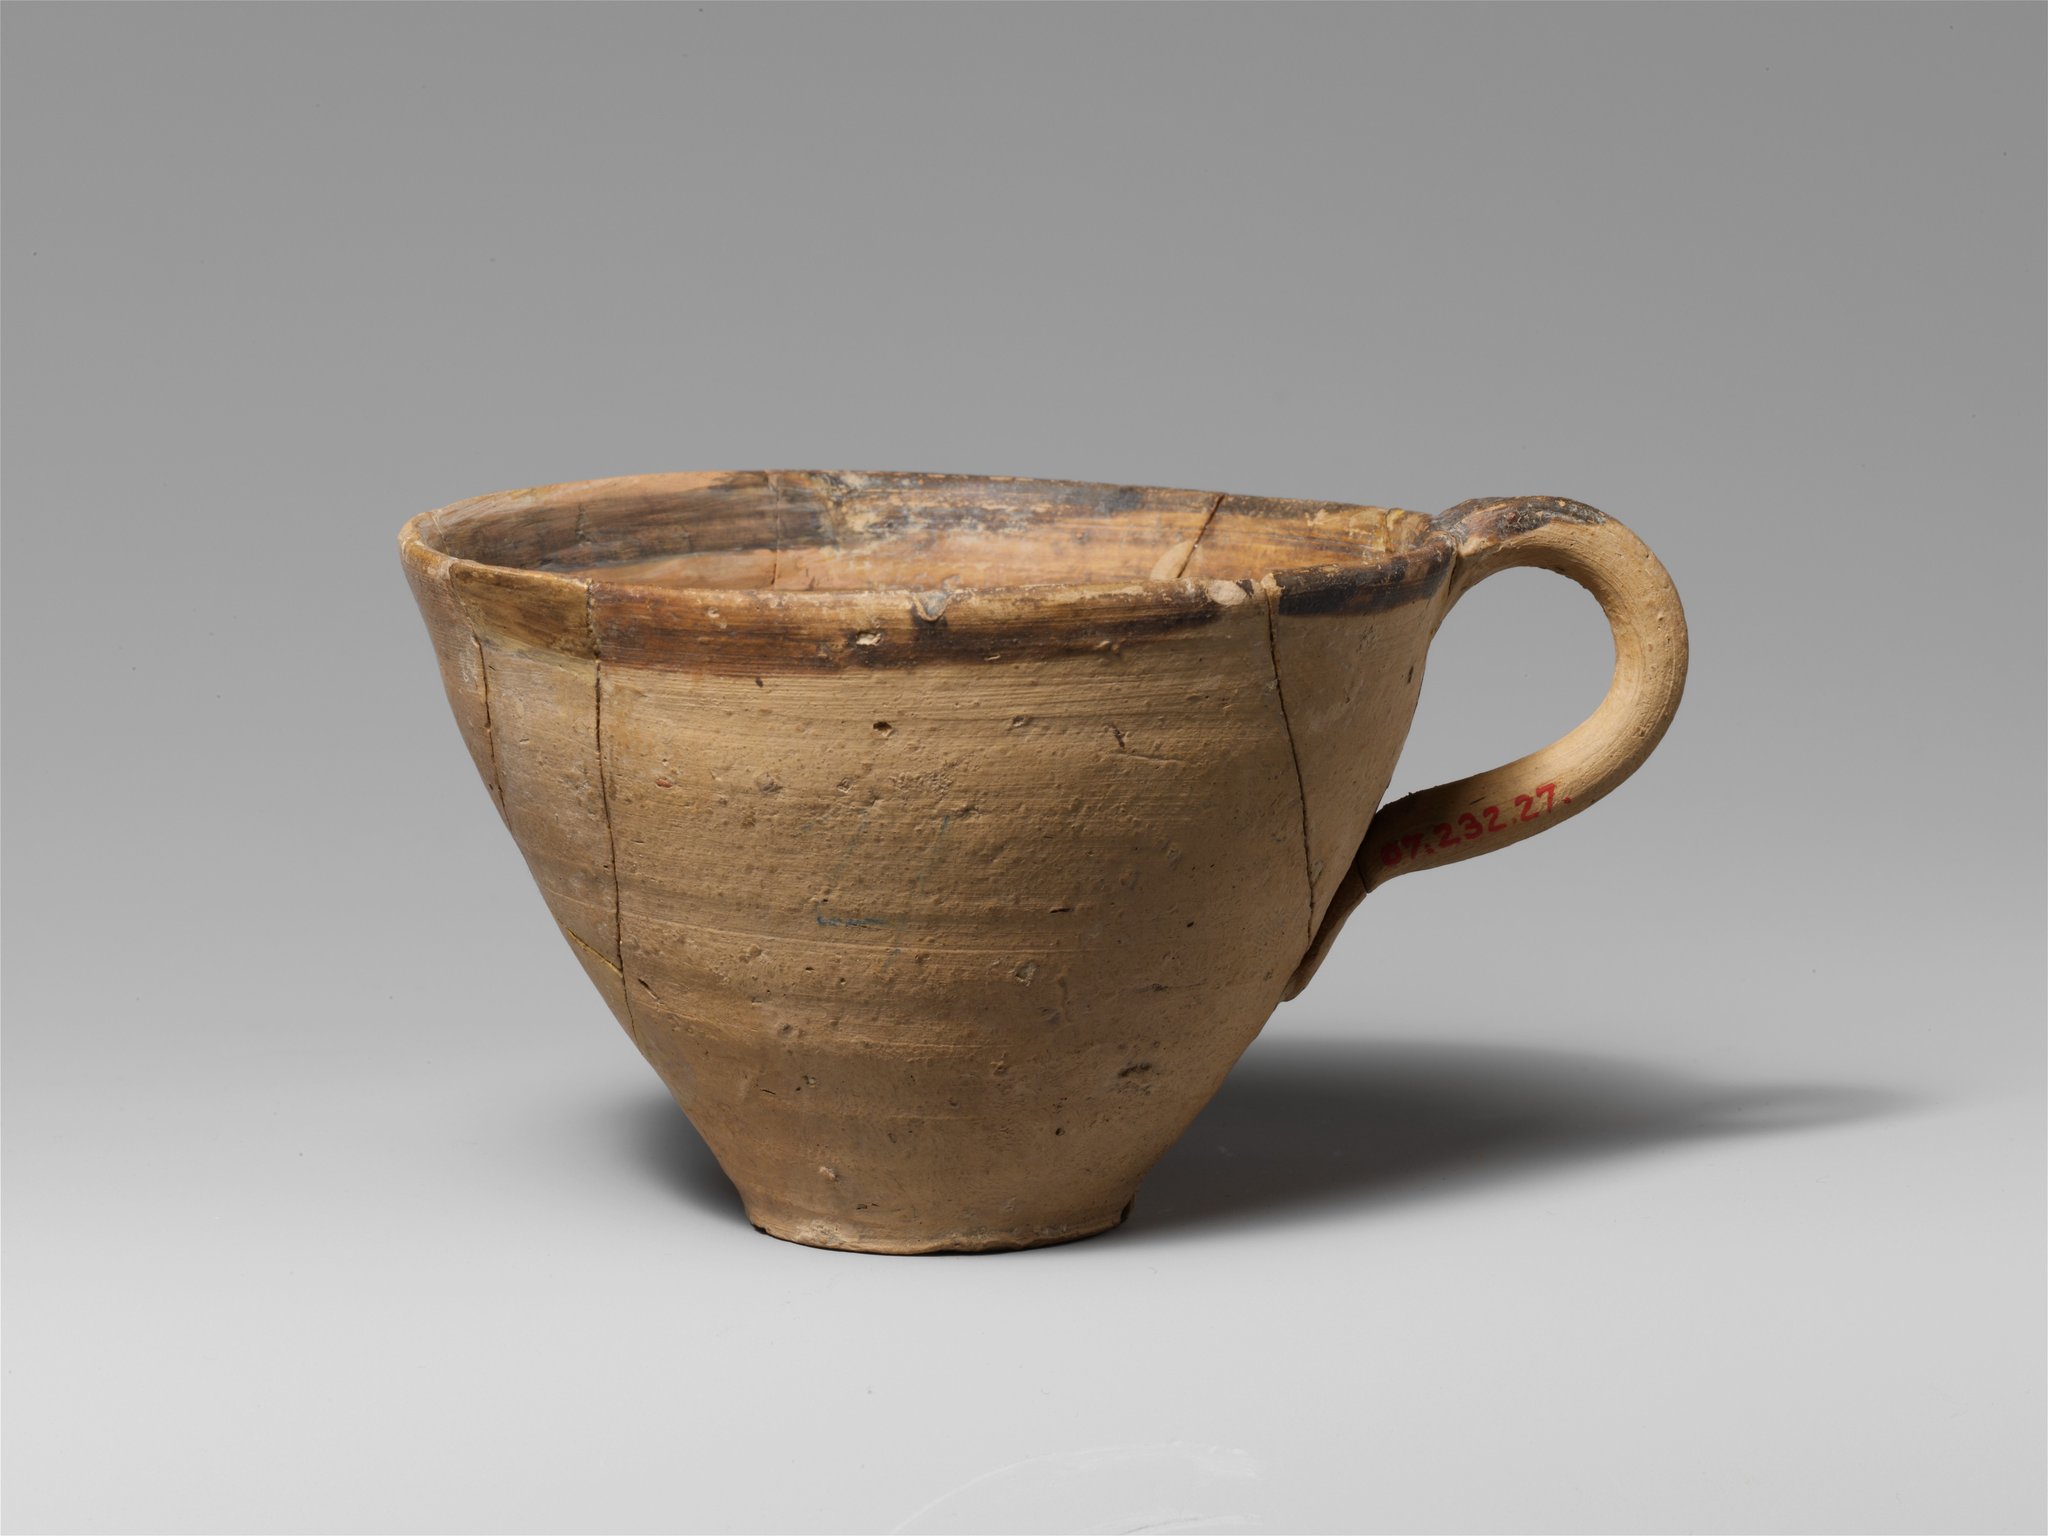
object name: cup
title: Terracotta one-handled cup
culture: minoan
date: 1600-1450 BCE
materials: terracotta